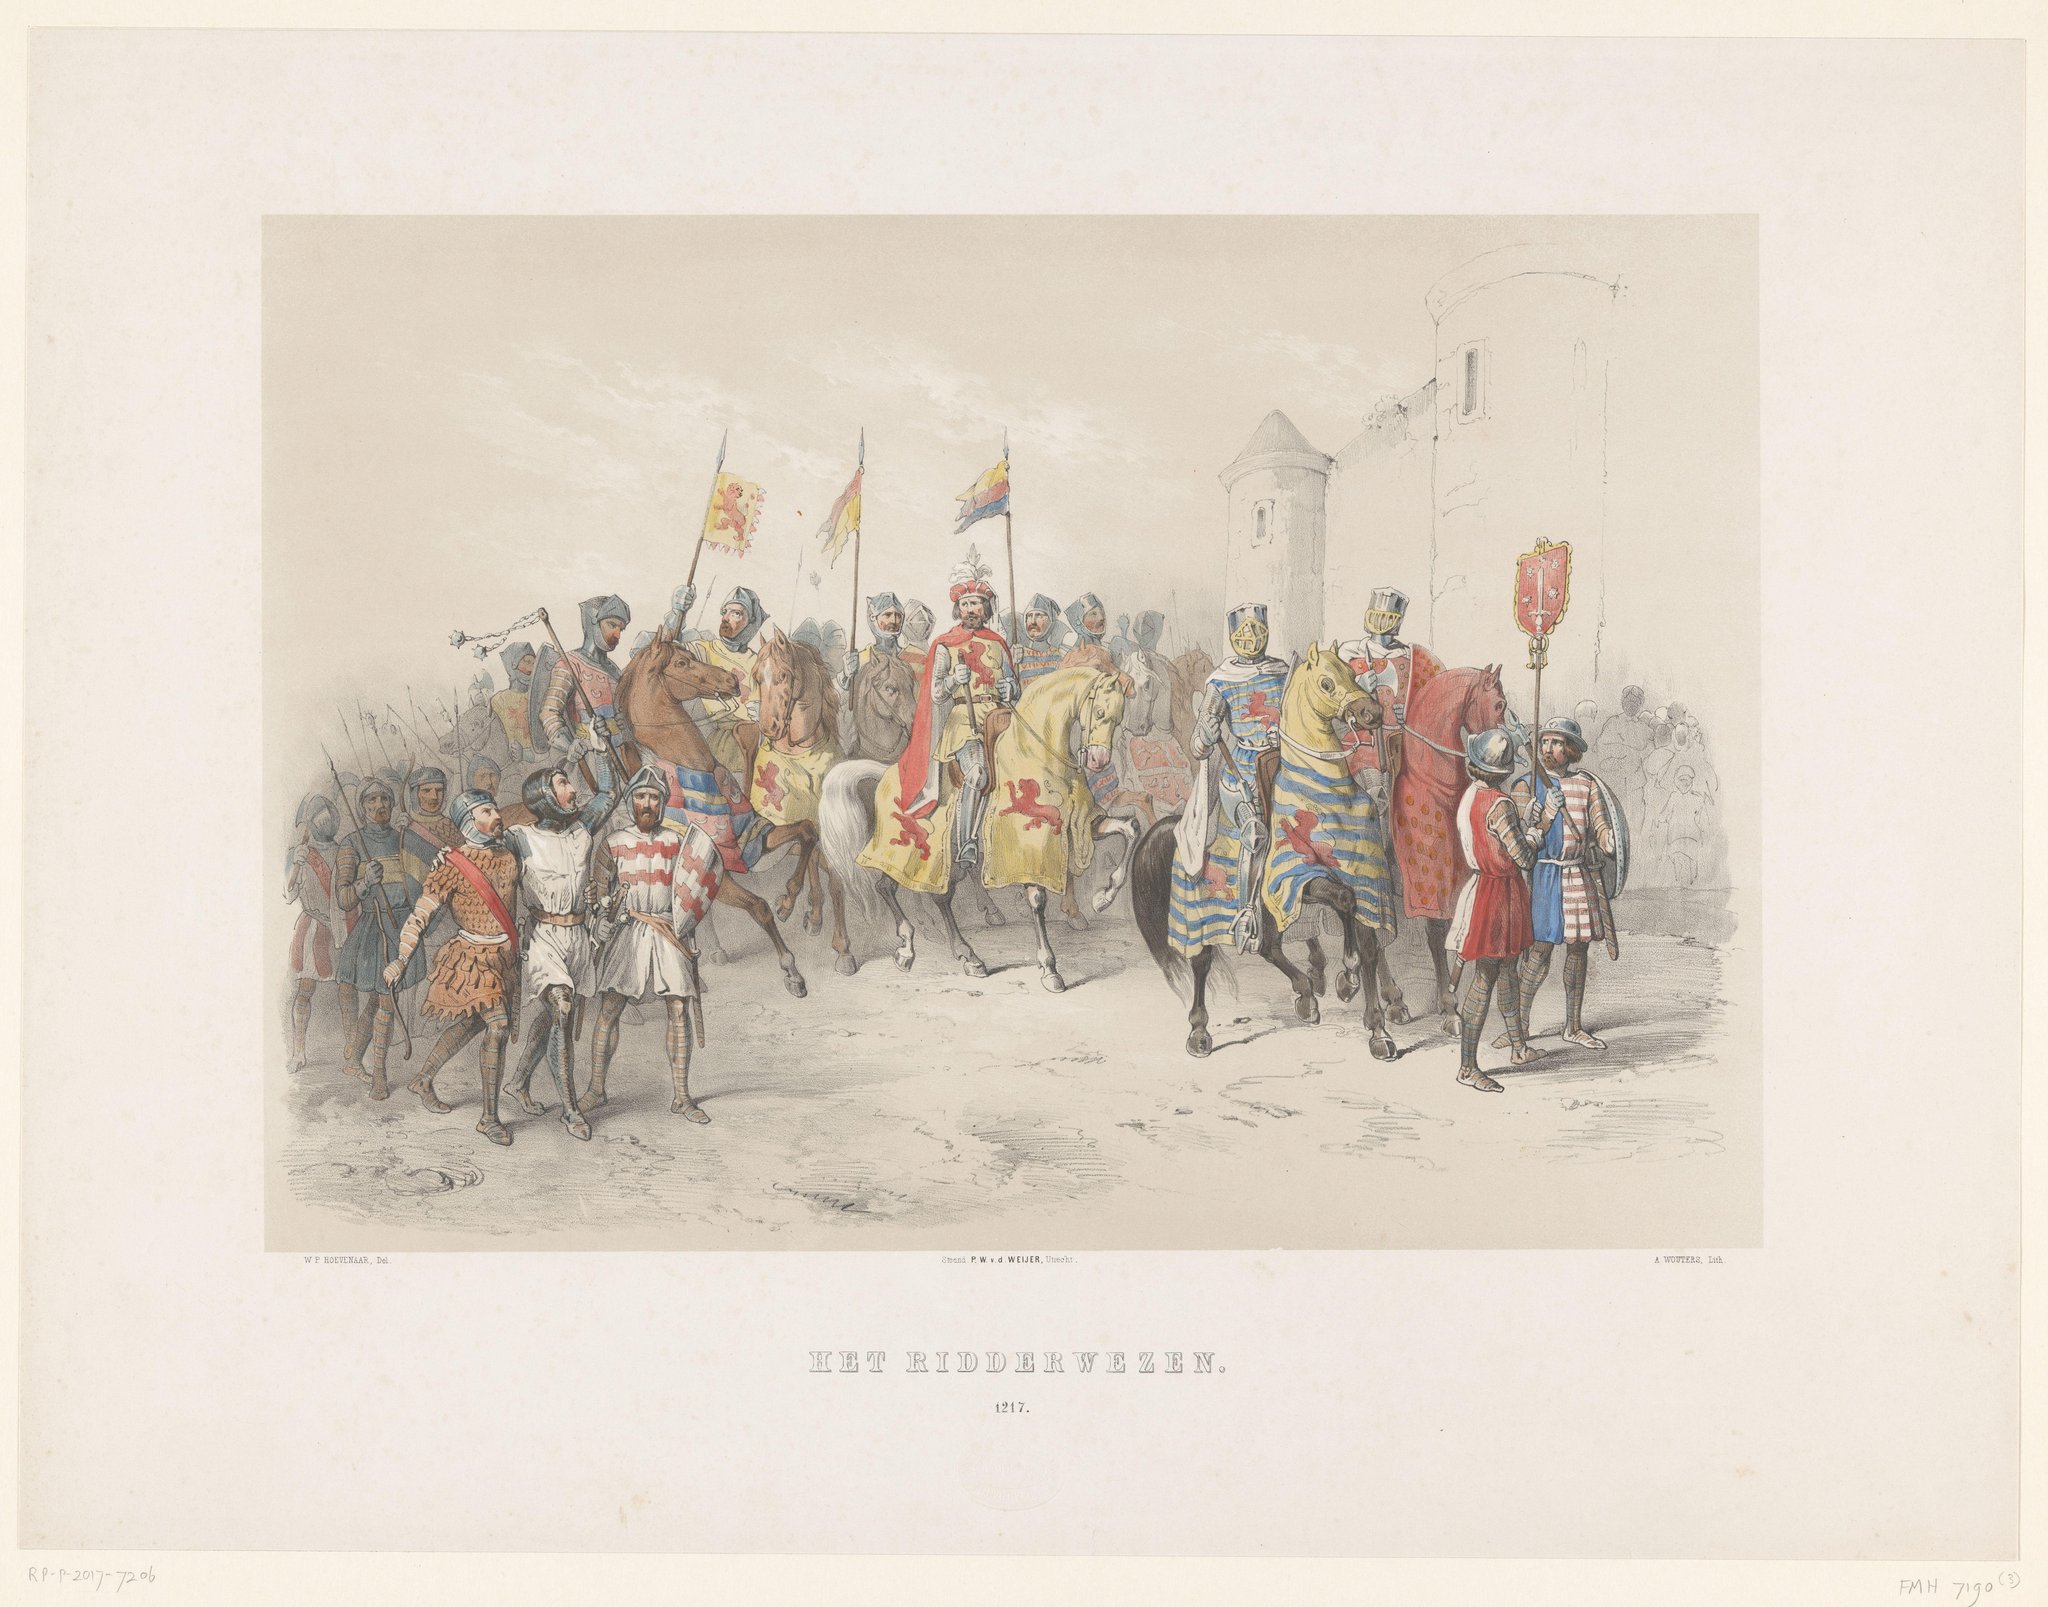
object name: print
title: De Vaderlandsche Geschiedenis. van de vroegste tijden tot op het einde der 17e eeuw, in acht taferelen, in costuum voorgesteld door H.H. Dtudenten der Utrechtsche Hoogeschool, den 25 Juny 1851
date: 1851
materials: paper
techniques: hand coloring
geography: utrecht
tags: students' pageant, militant proselytizing: religious war, crusade, etc., haarlem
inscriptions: workshop stamp: ‘Dannenfelser & Doorman Uitgevers Utrecht’, collector's mark: Lugt 2228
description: Episode uit de riddertijd in Nederland, 1217. Terugkeer van Willem I, graaf van Holland, van de kruistocht en de inname van Damiate. Onderdeel van de serie van acht prenten van de maskerade van de studenten van de Utrechtse Hogeschool voorstellende episodes uit de vaderlandse geschiedenis, 25 juni 1851.